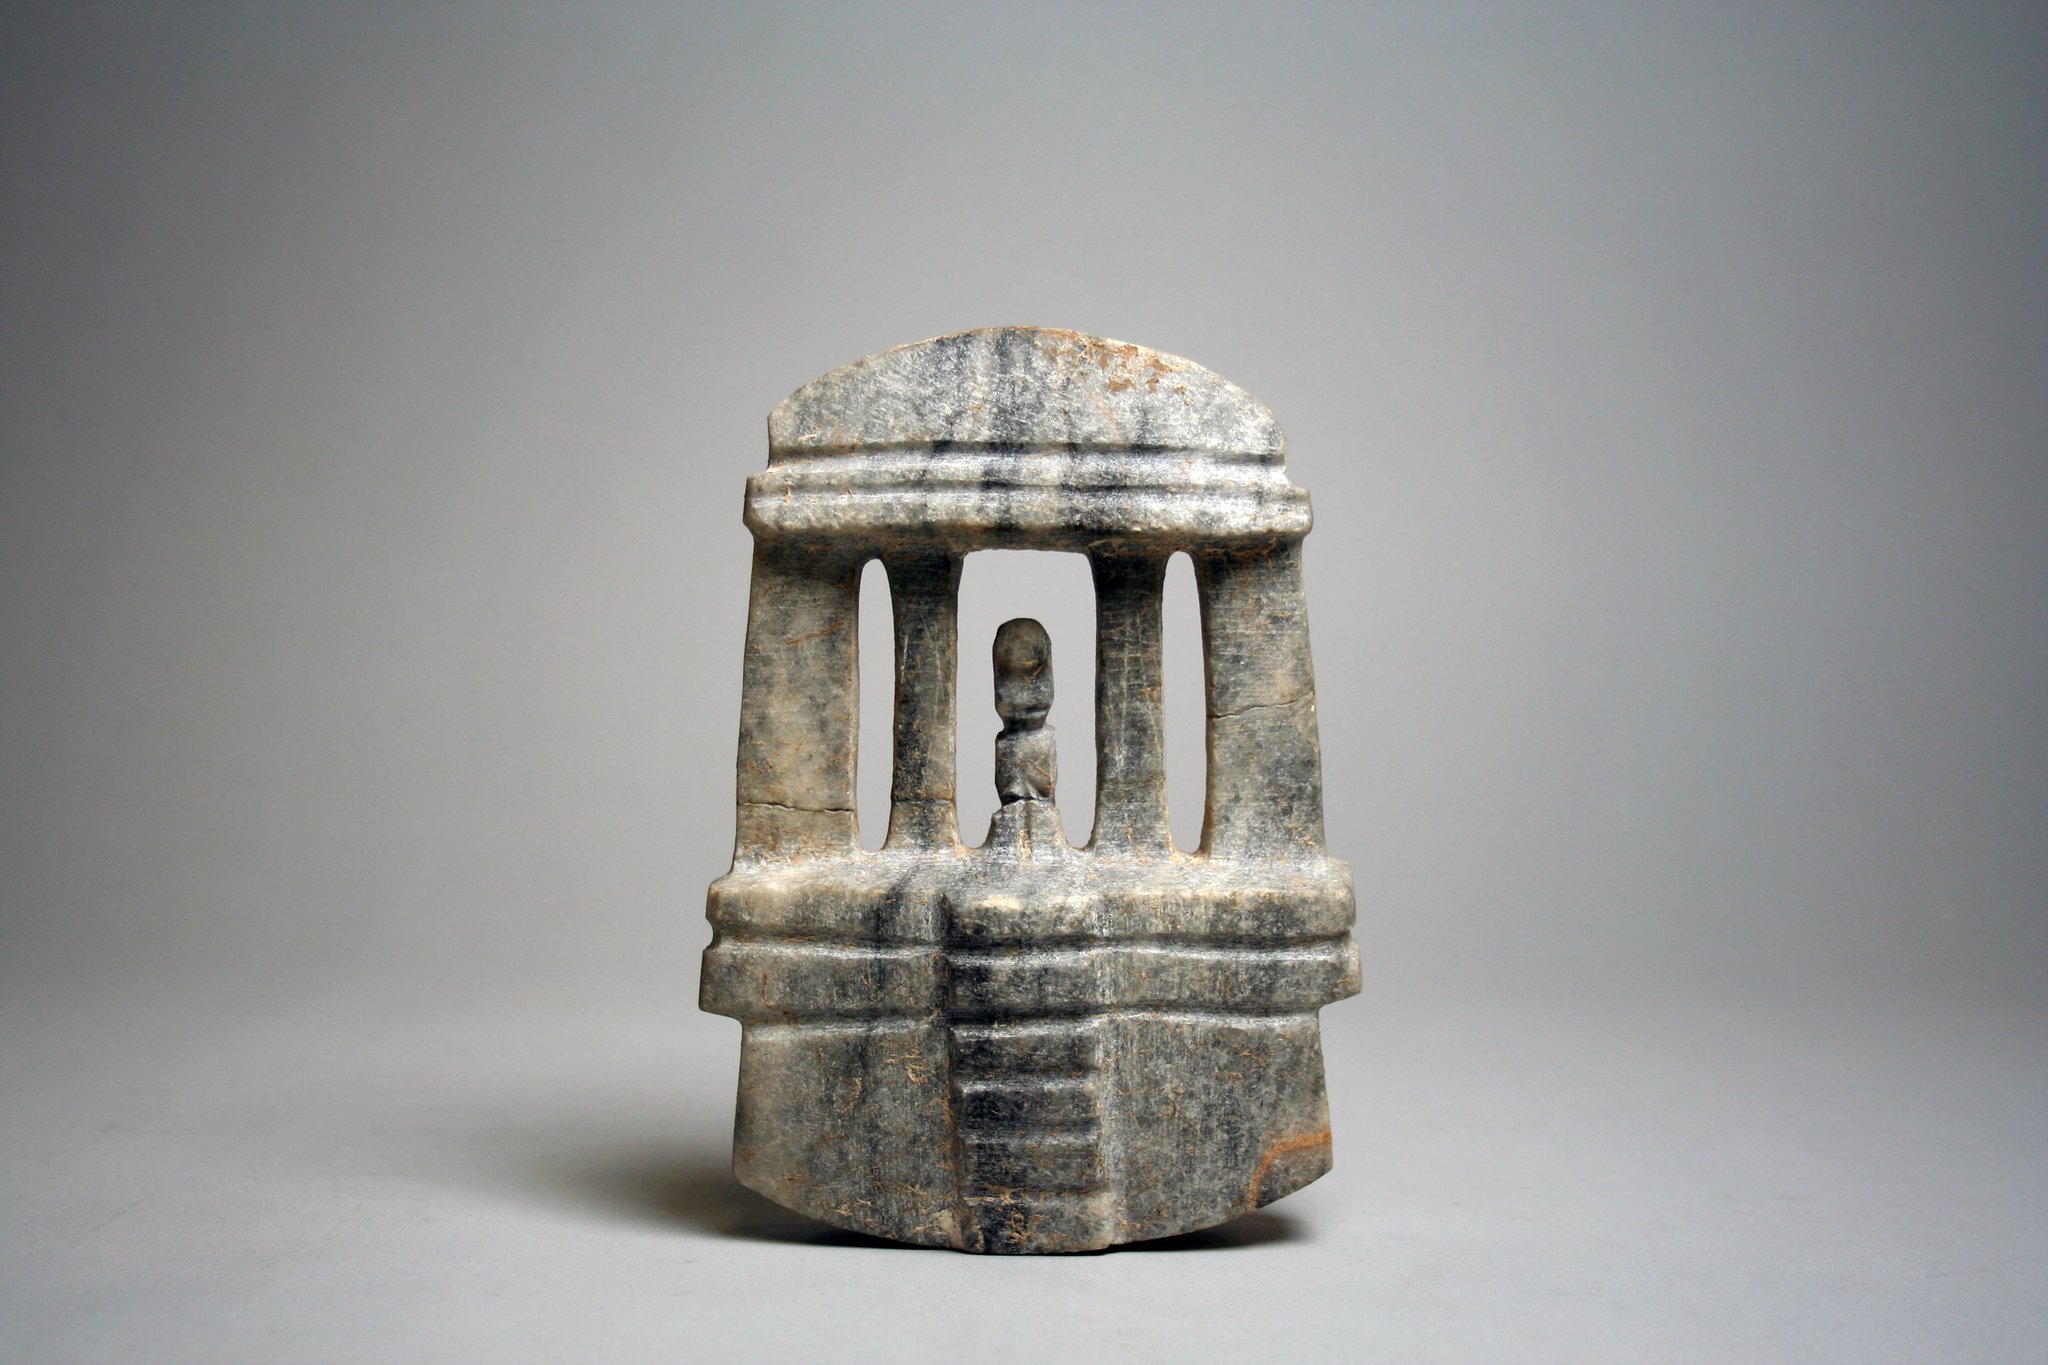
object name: architectural model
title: Architectural Model with Figure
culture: mezcala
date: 1-800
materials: stone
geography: mexico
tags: temples